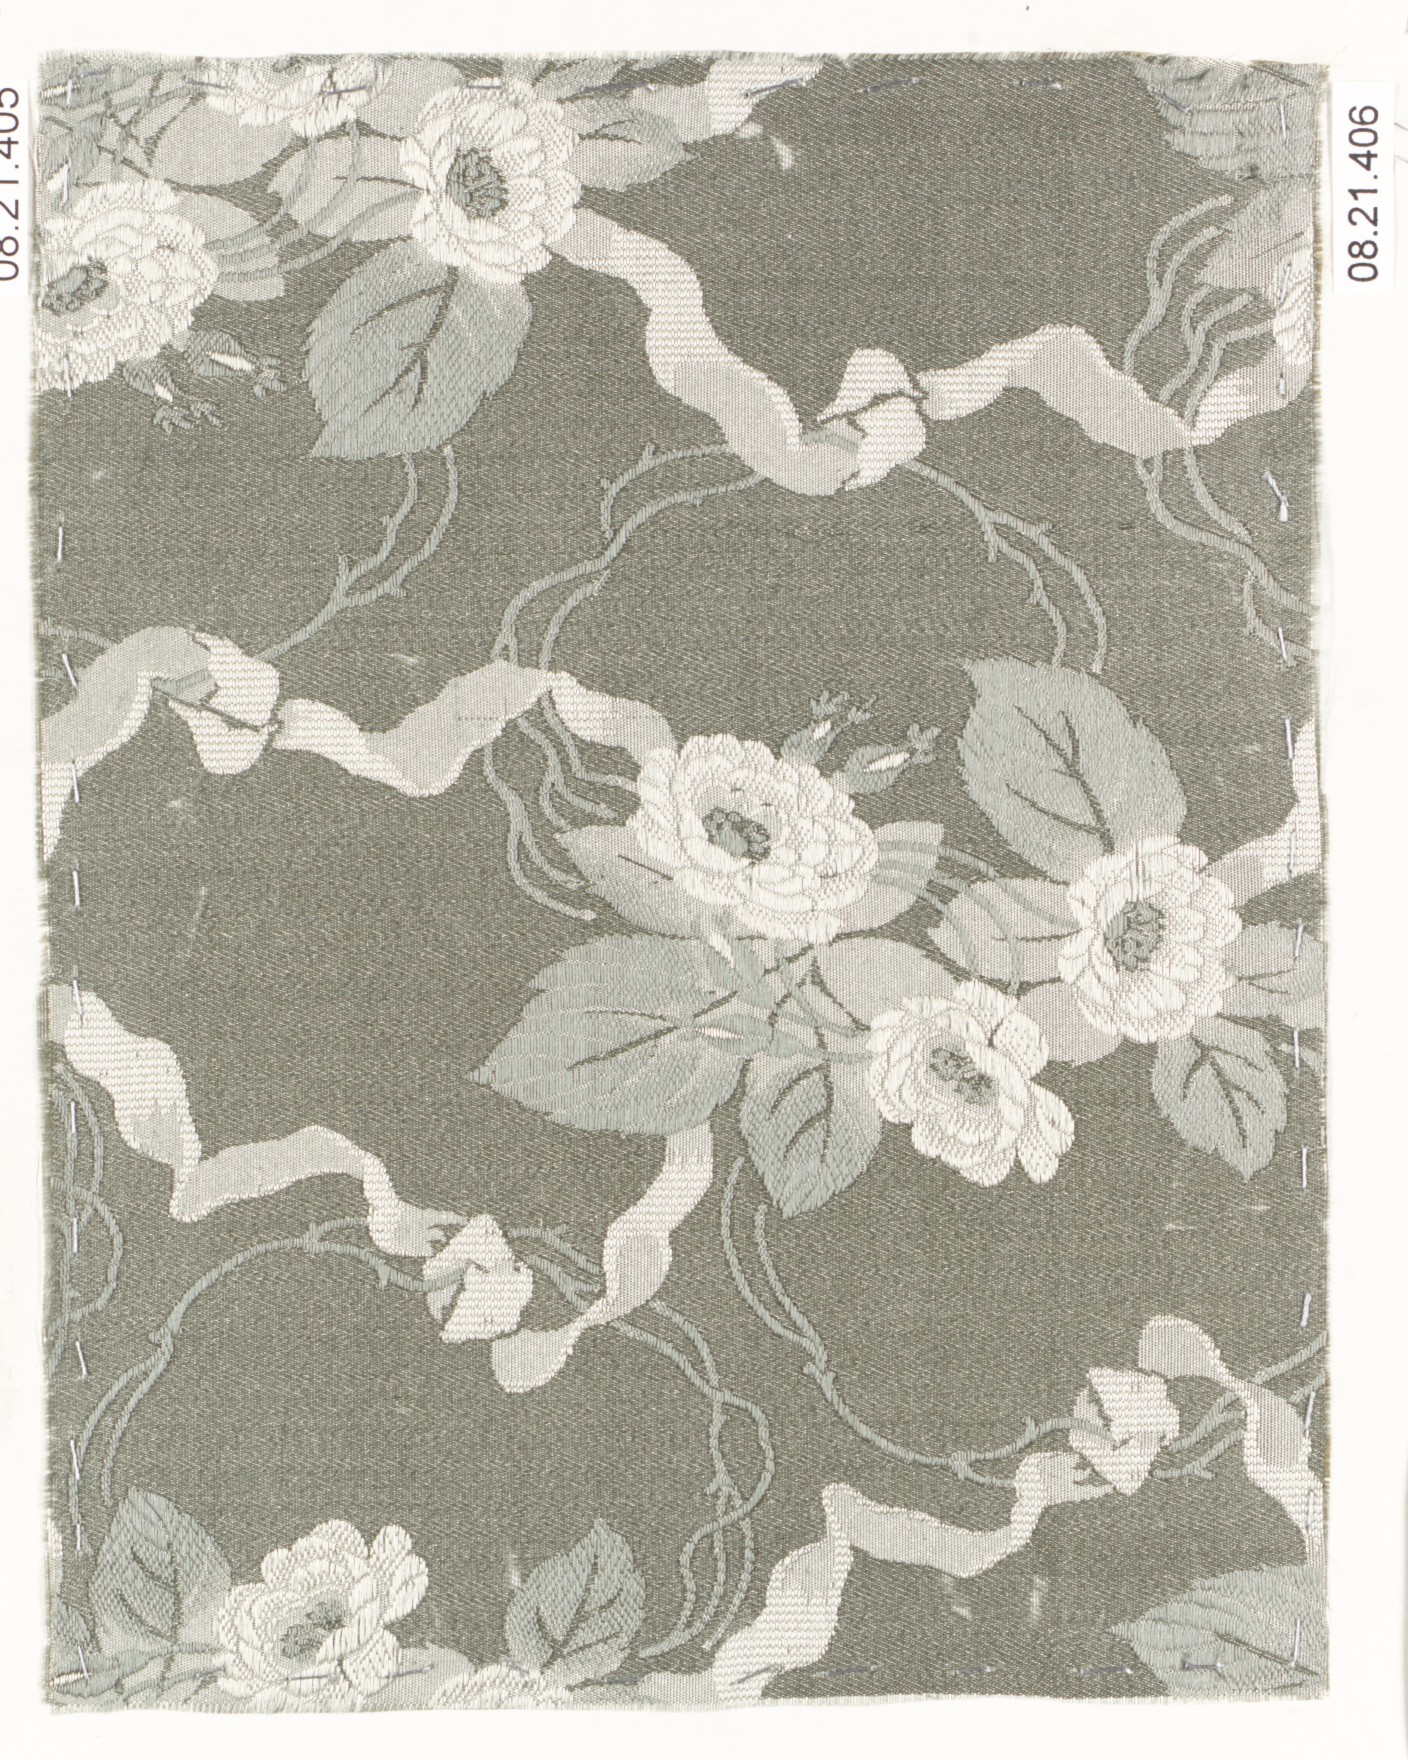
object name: textile sample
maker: Anonymous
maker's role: designer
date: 1900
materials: silk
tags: roses,leaves